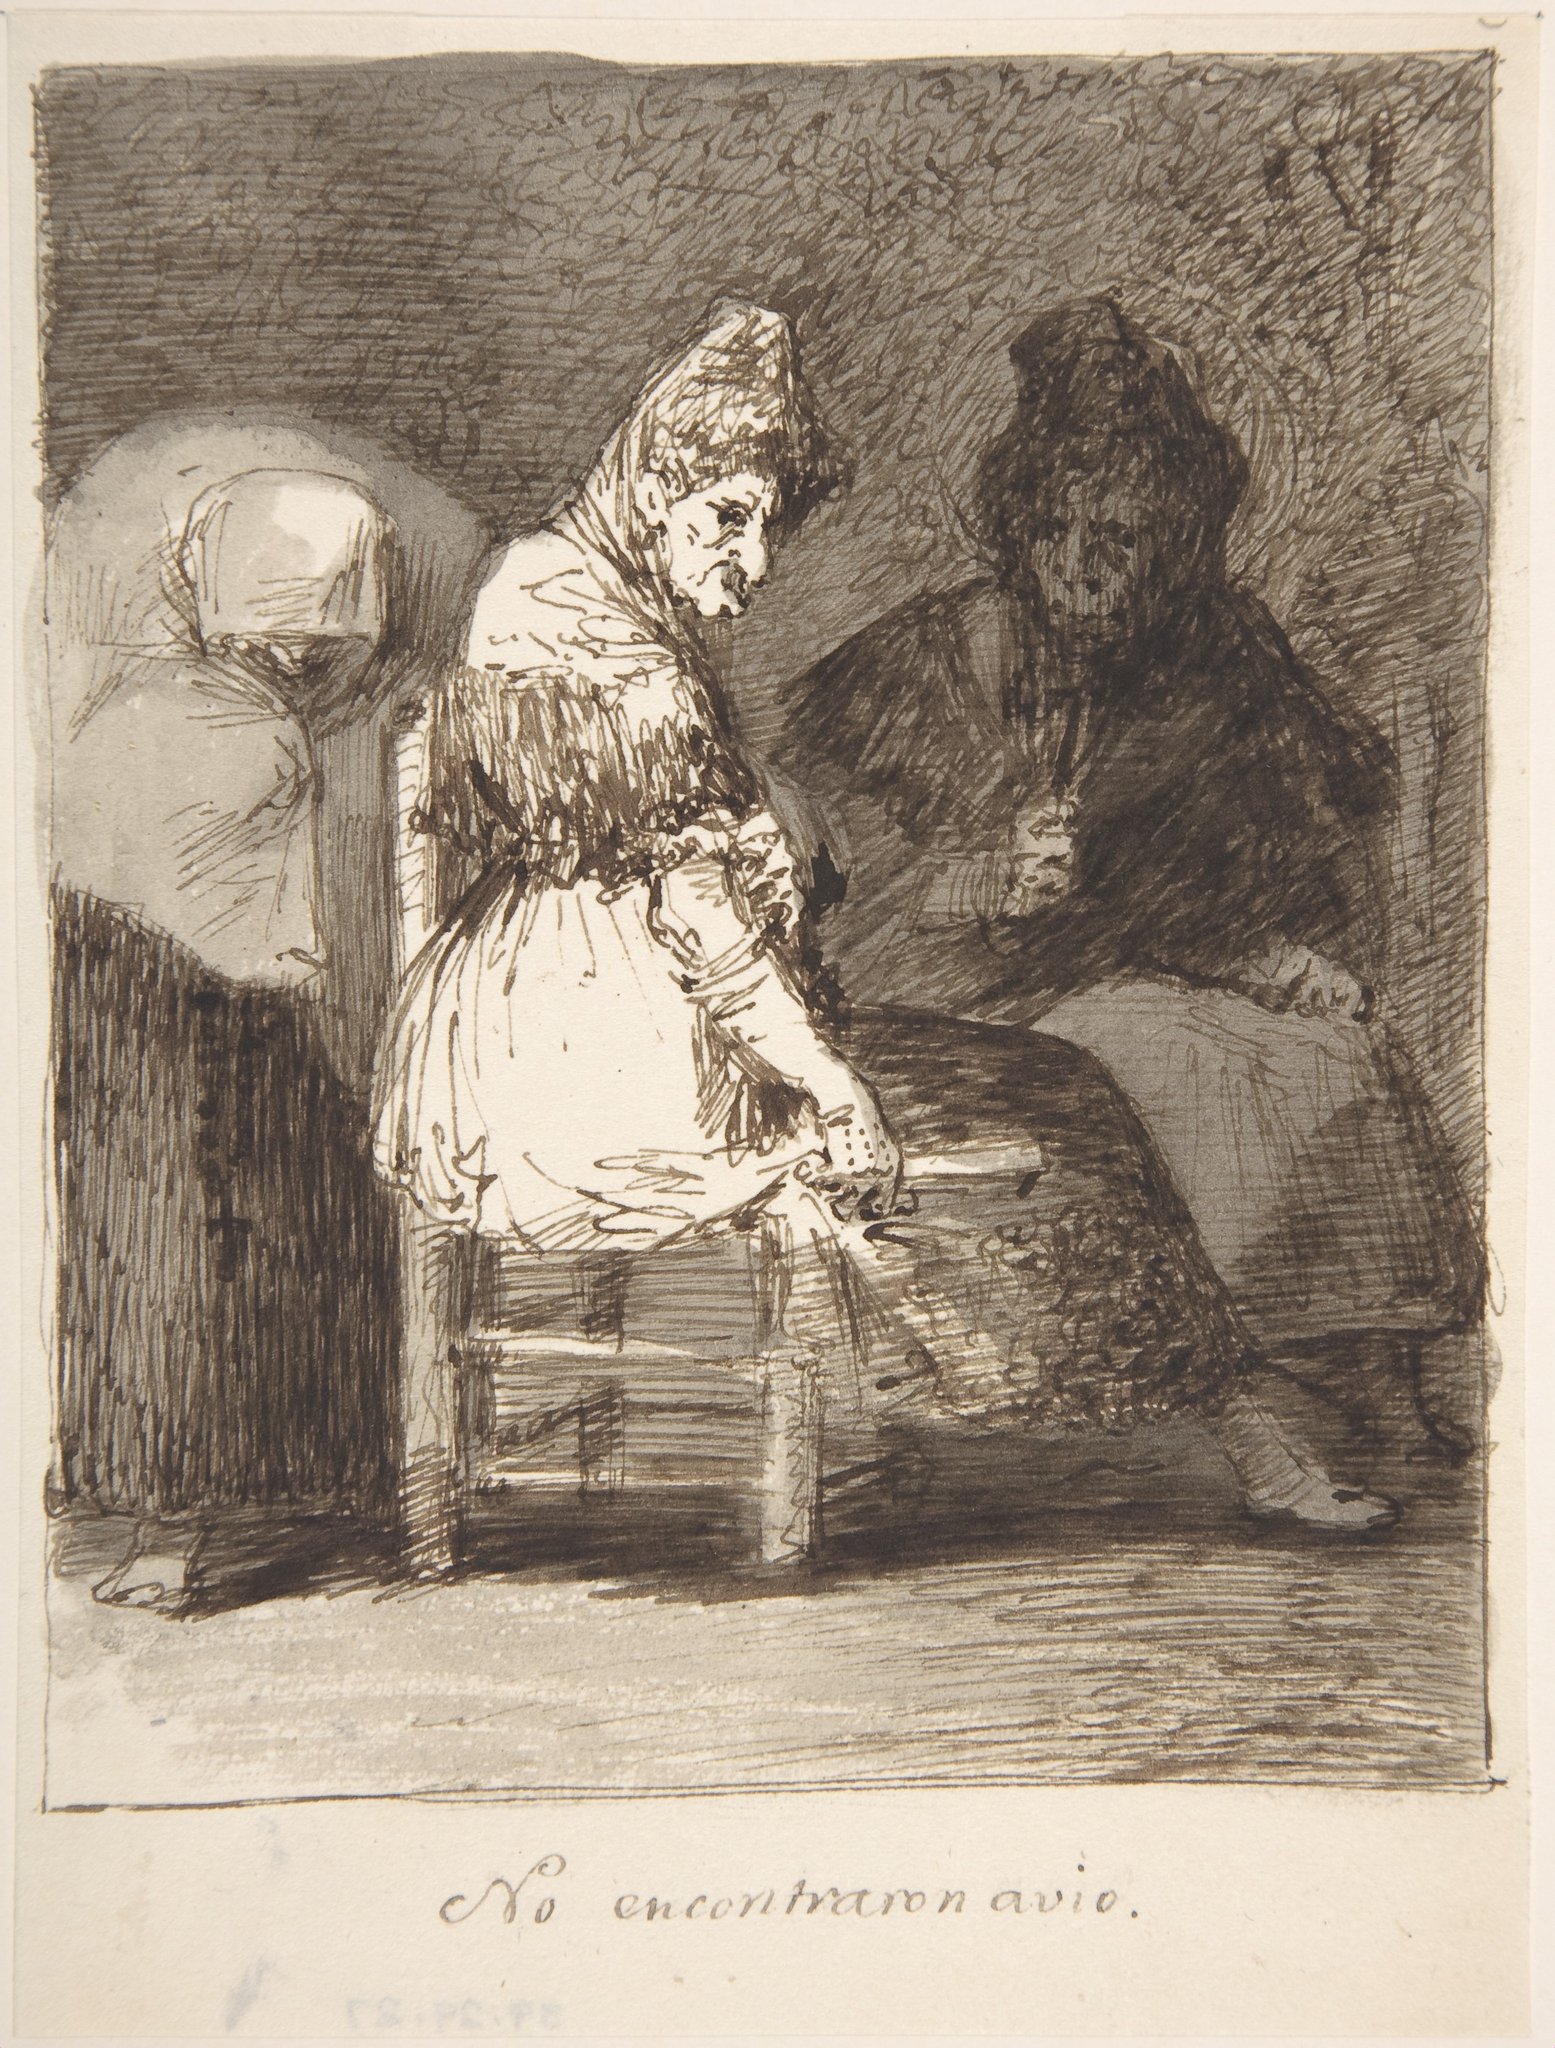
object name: drawing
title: There Was No Business (No encontraron avio)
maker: leonardo alenza y nieto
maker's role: artist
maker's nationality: spanish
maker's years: 1807-1845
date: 1807-1845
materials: ink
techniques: brush, pen, wash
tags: human figures,chairs